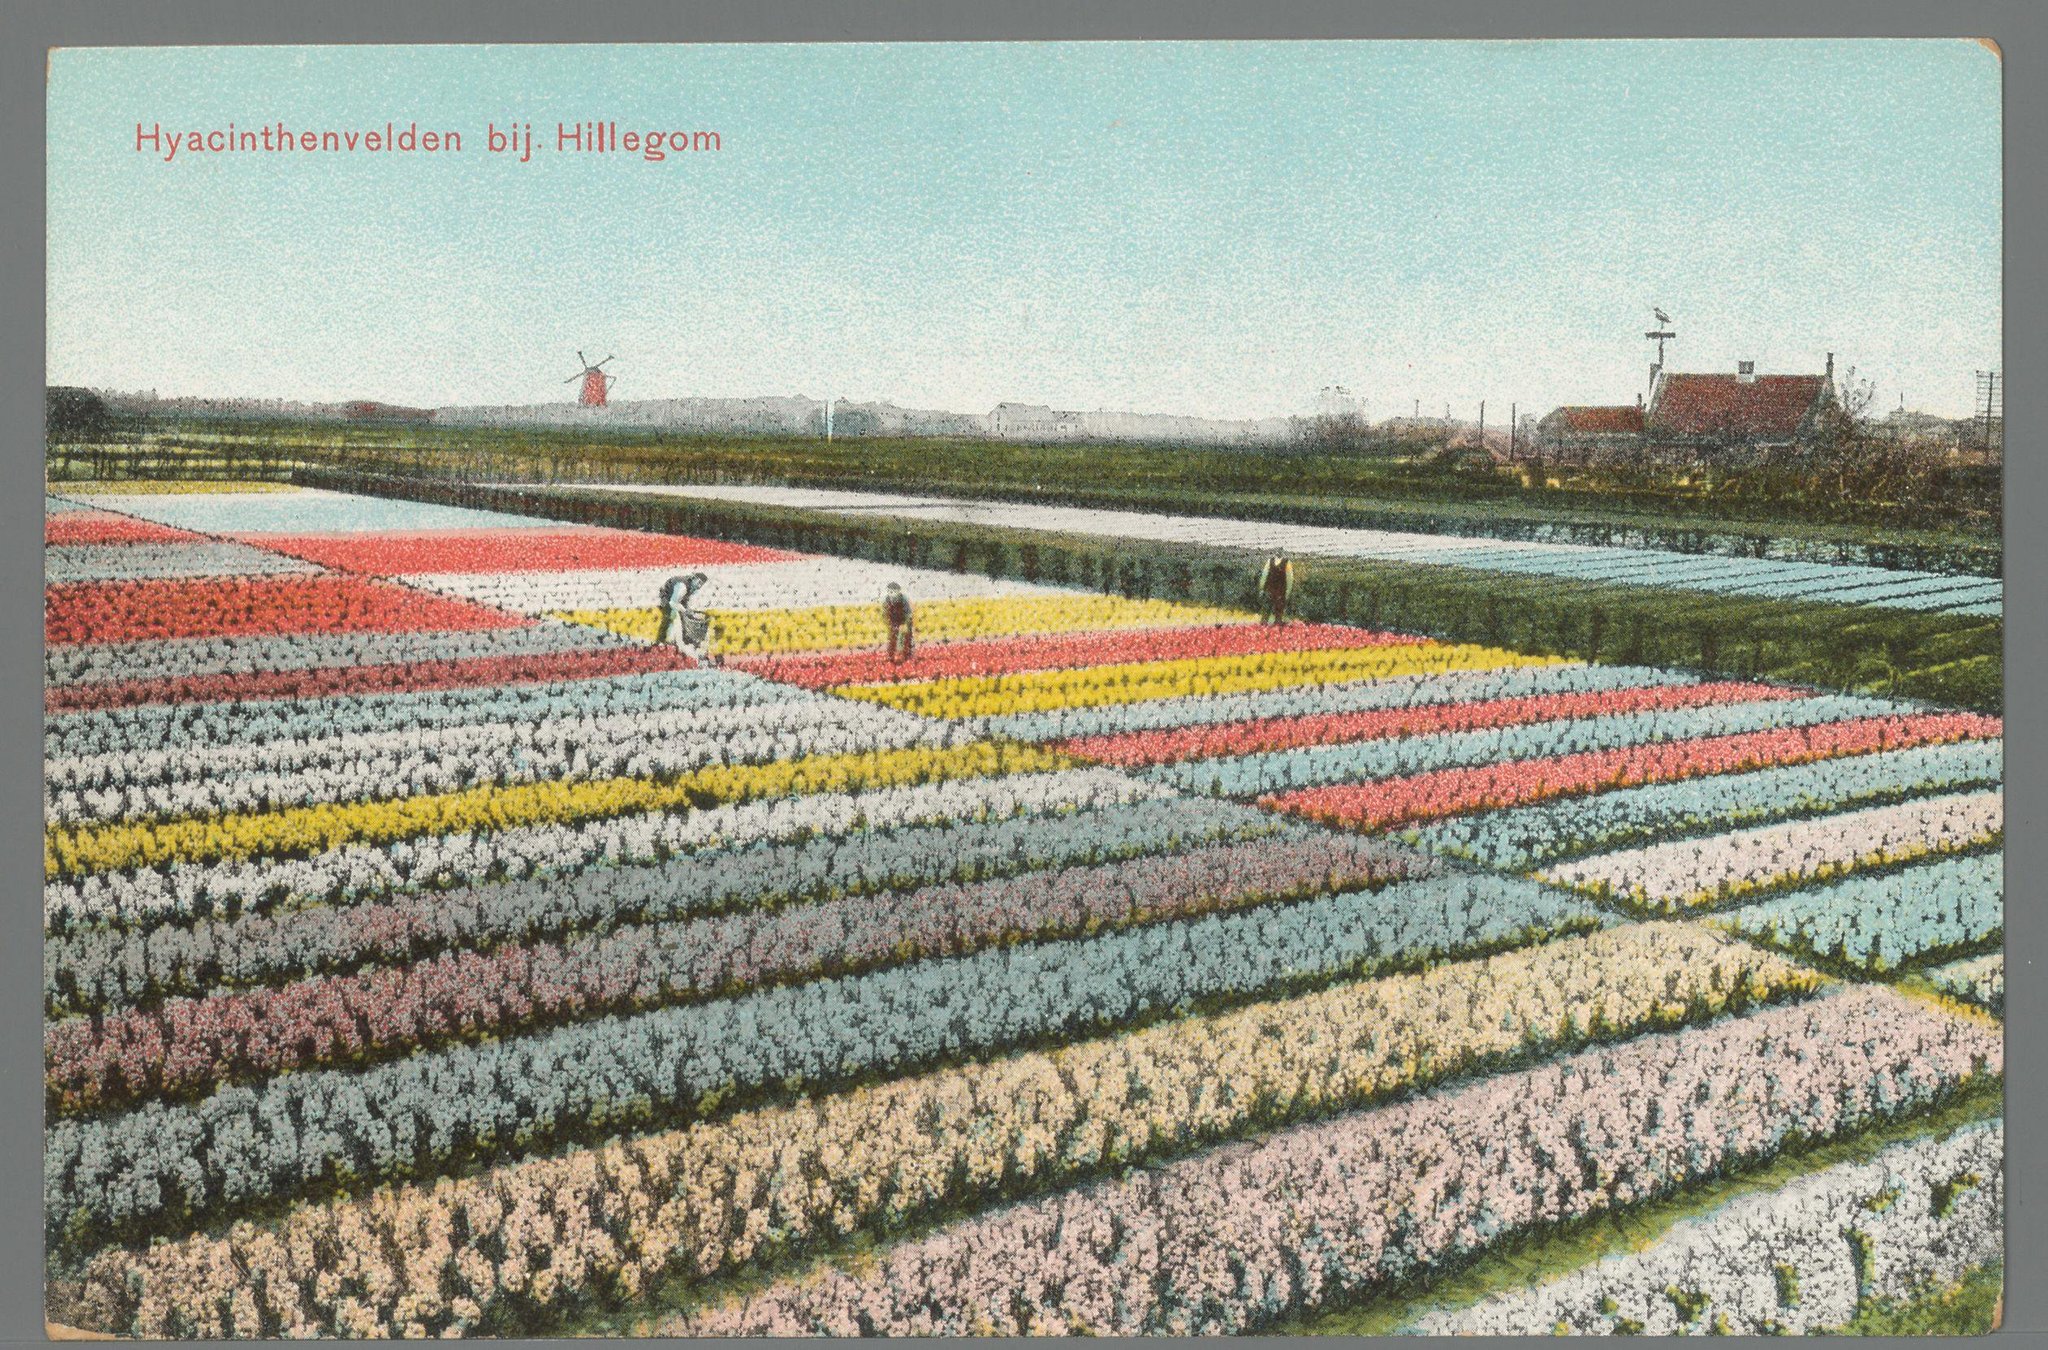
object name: ansichtkaart, prentbriefkaart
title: Hyacinthenvelden bij Hillegom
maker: Anonymous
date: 1907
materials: cardboard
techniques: lithograph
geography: leipzig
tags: bulb field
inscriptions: date